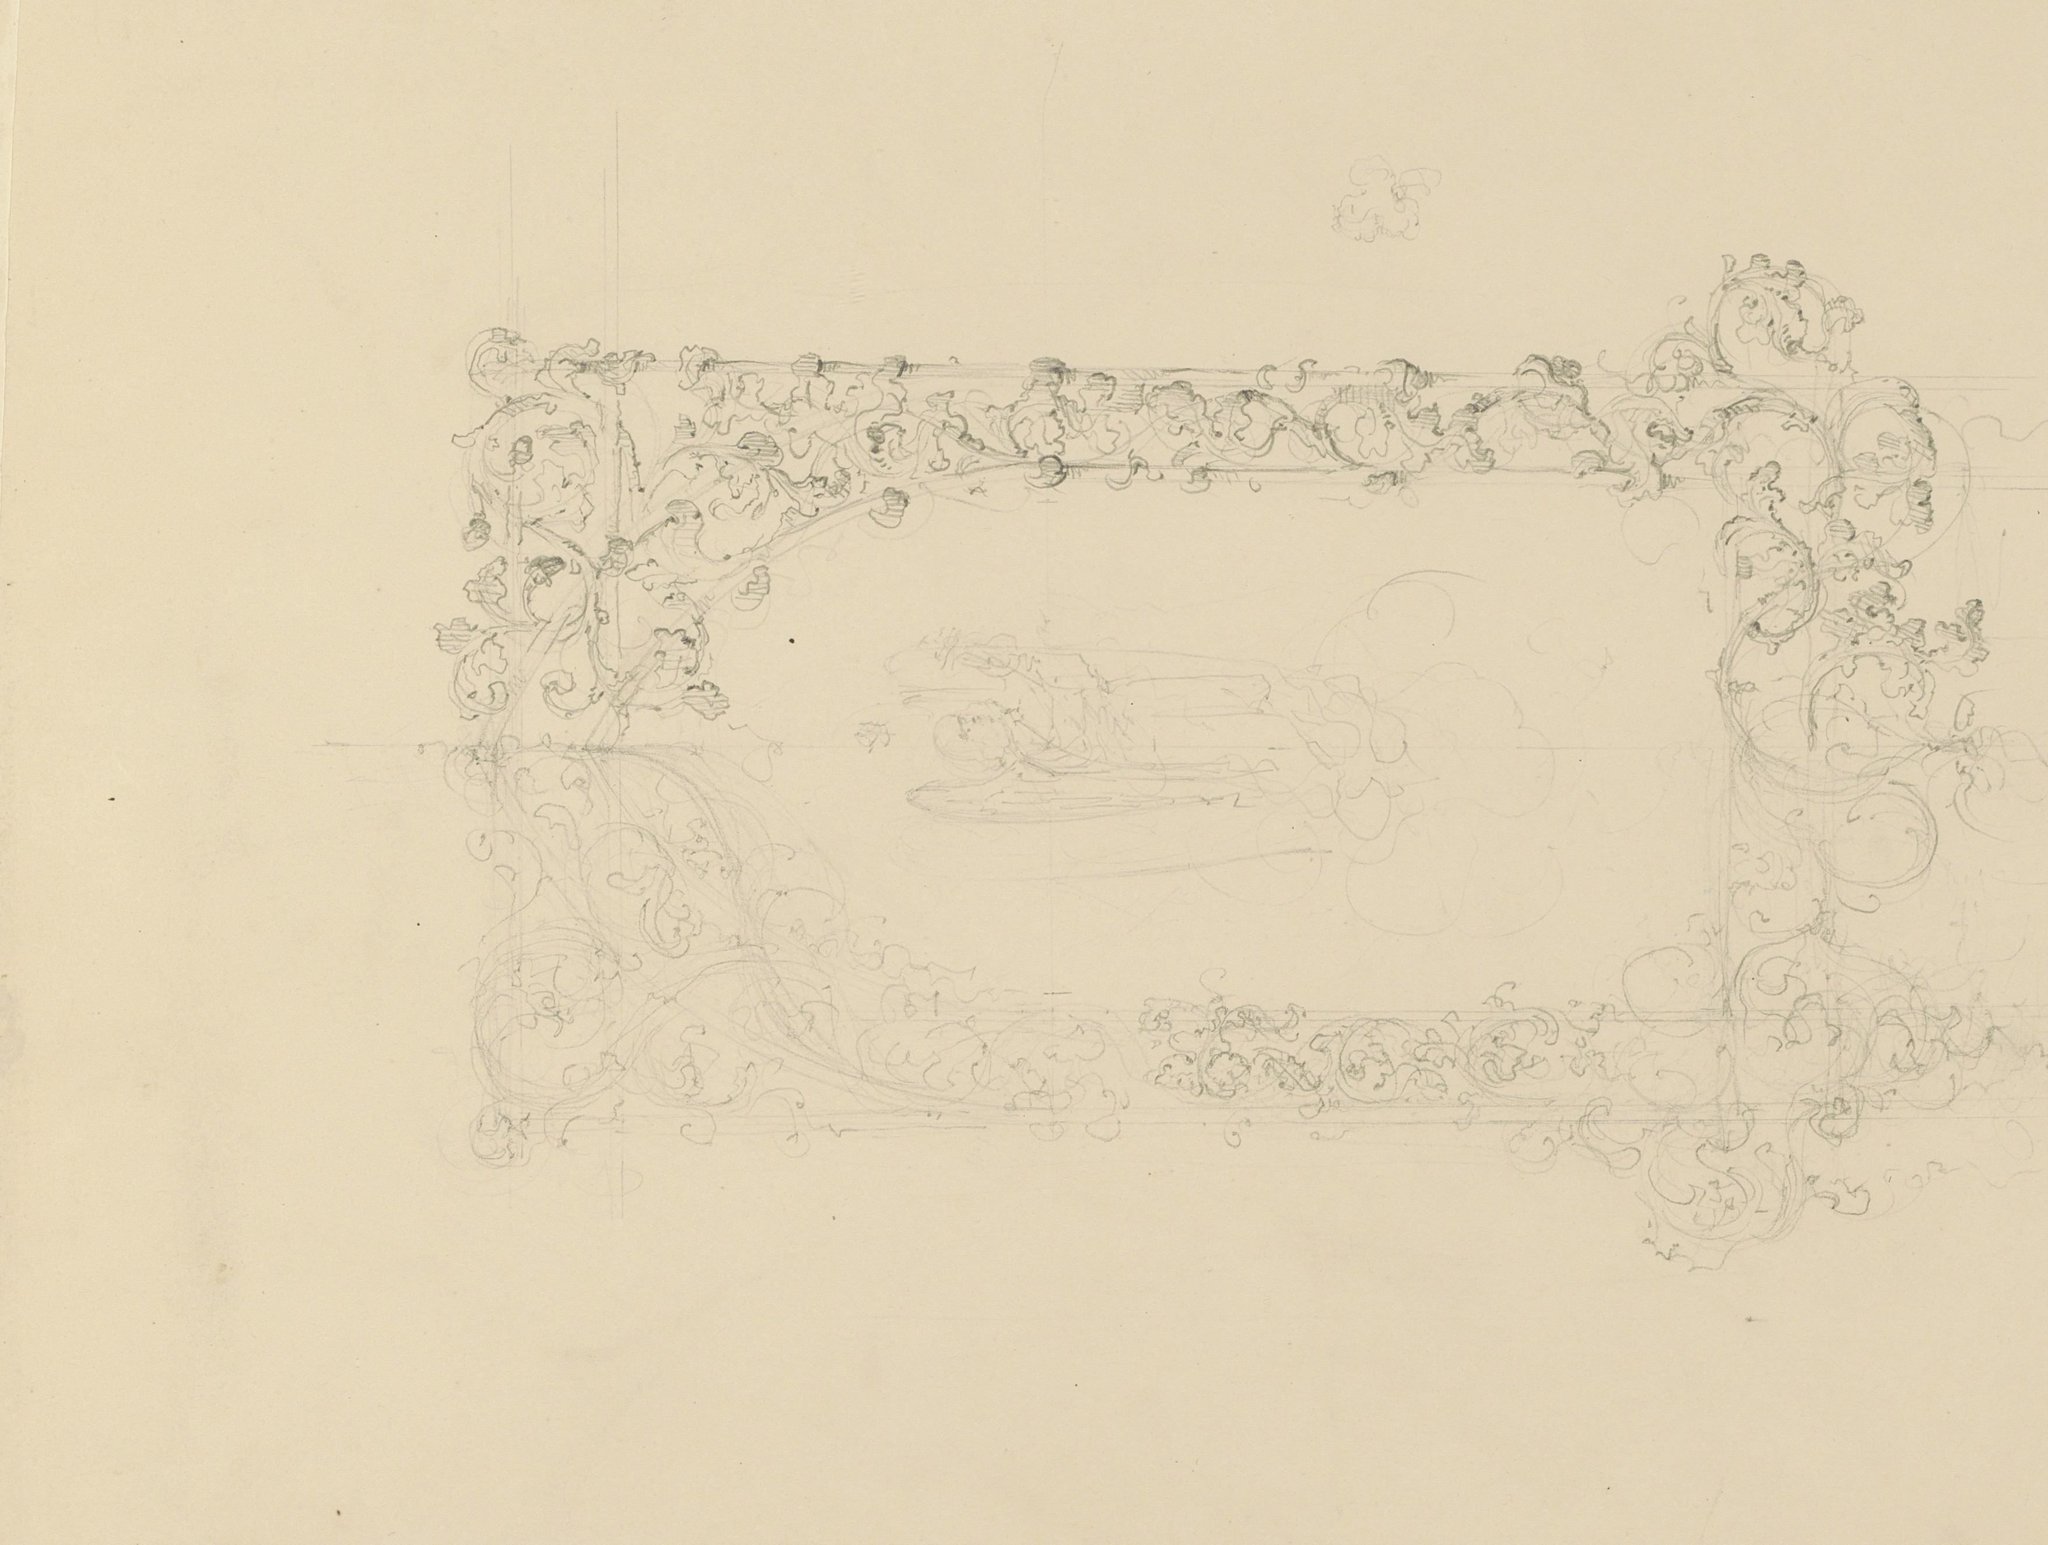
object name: sketchbook leaf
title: Engel in een cartouche van bladeren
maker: pierre joseph hubert cuypers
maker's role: draughtsman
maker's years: 1827-1921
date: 1850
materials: paper, pencil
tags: ornament ~ cartouche, angels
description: Blad 24 recto uit een schetsboek met 37 bladen.